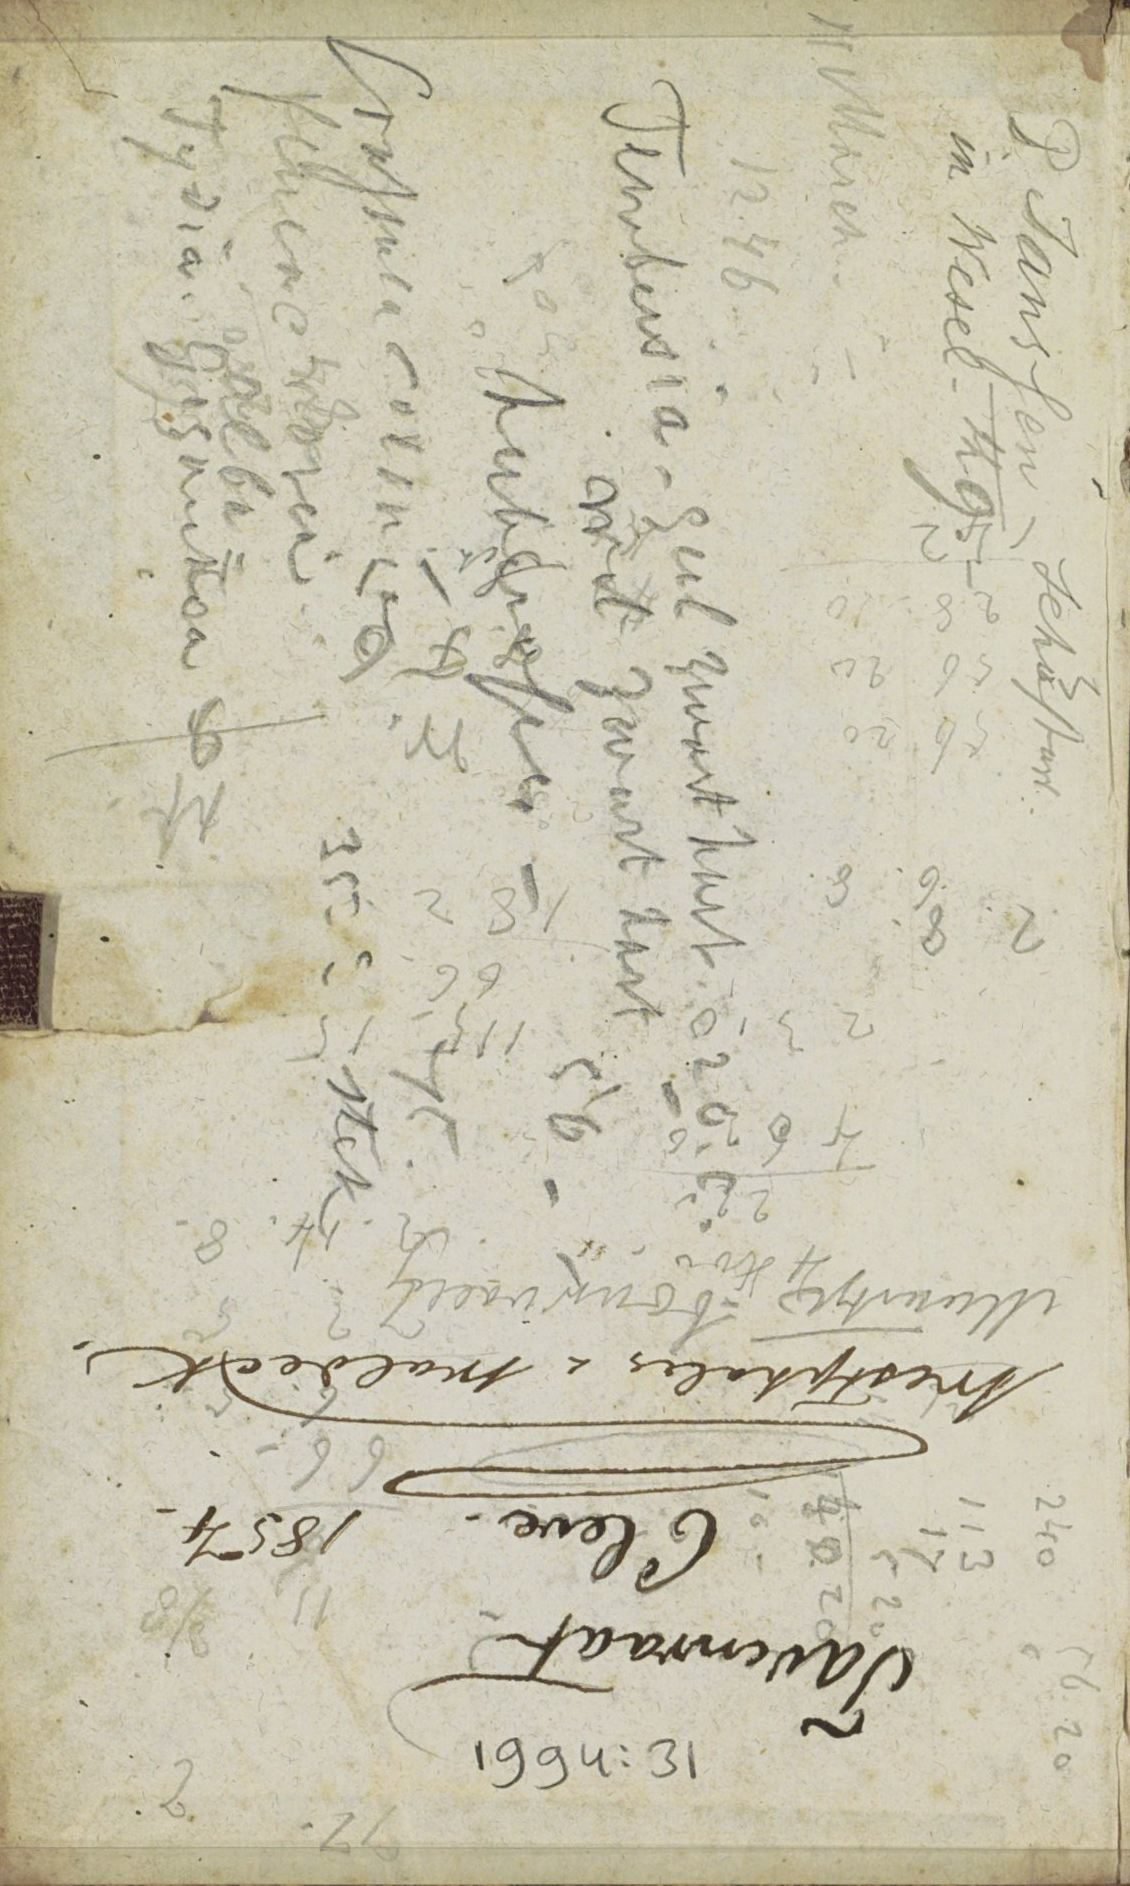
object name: sketchbook leaf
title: Notities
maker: johannes tavenraat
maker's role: draughtsman, painter, print maker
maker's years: 1809-1881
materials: ink, paper, pencil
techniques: pen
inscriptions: signature and date: ‘Tavenraat/ Cleve. 1854./ Westphalen & Waldeck’, annotation: ‘[...]’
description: Voorste schutblad uit een schetsboek met 88 bladen.